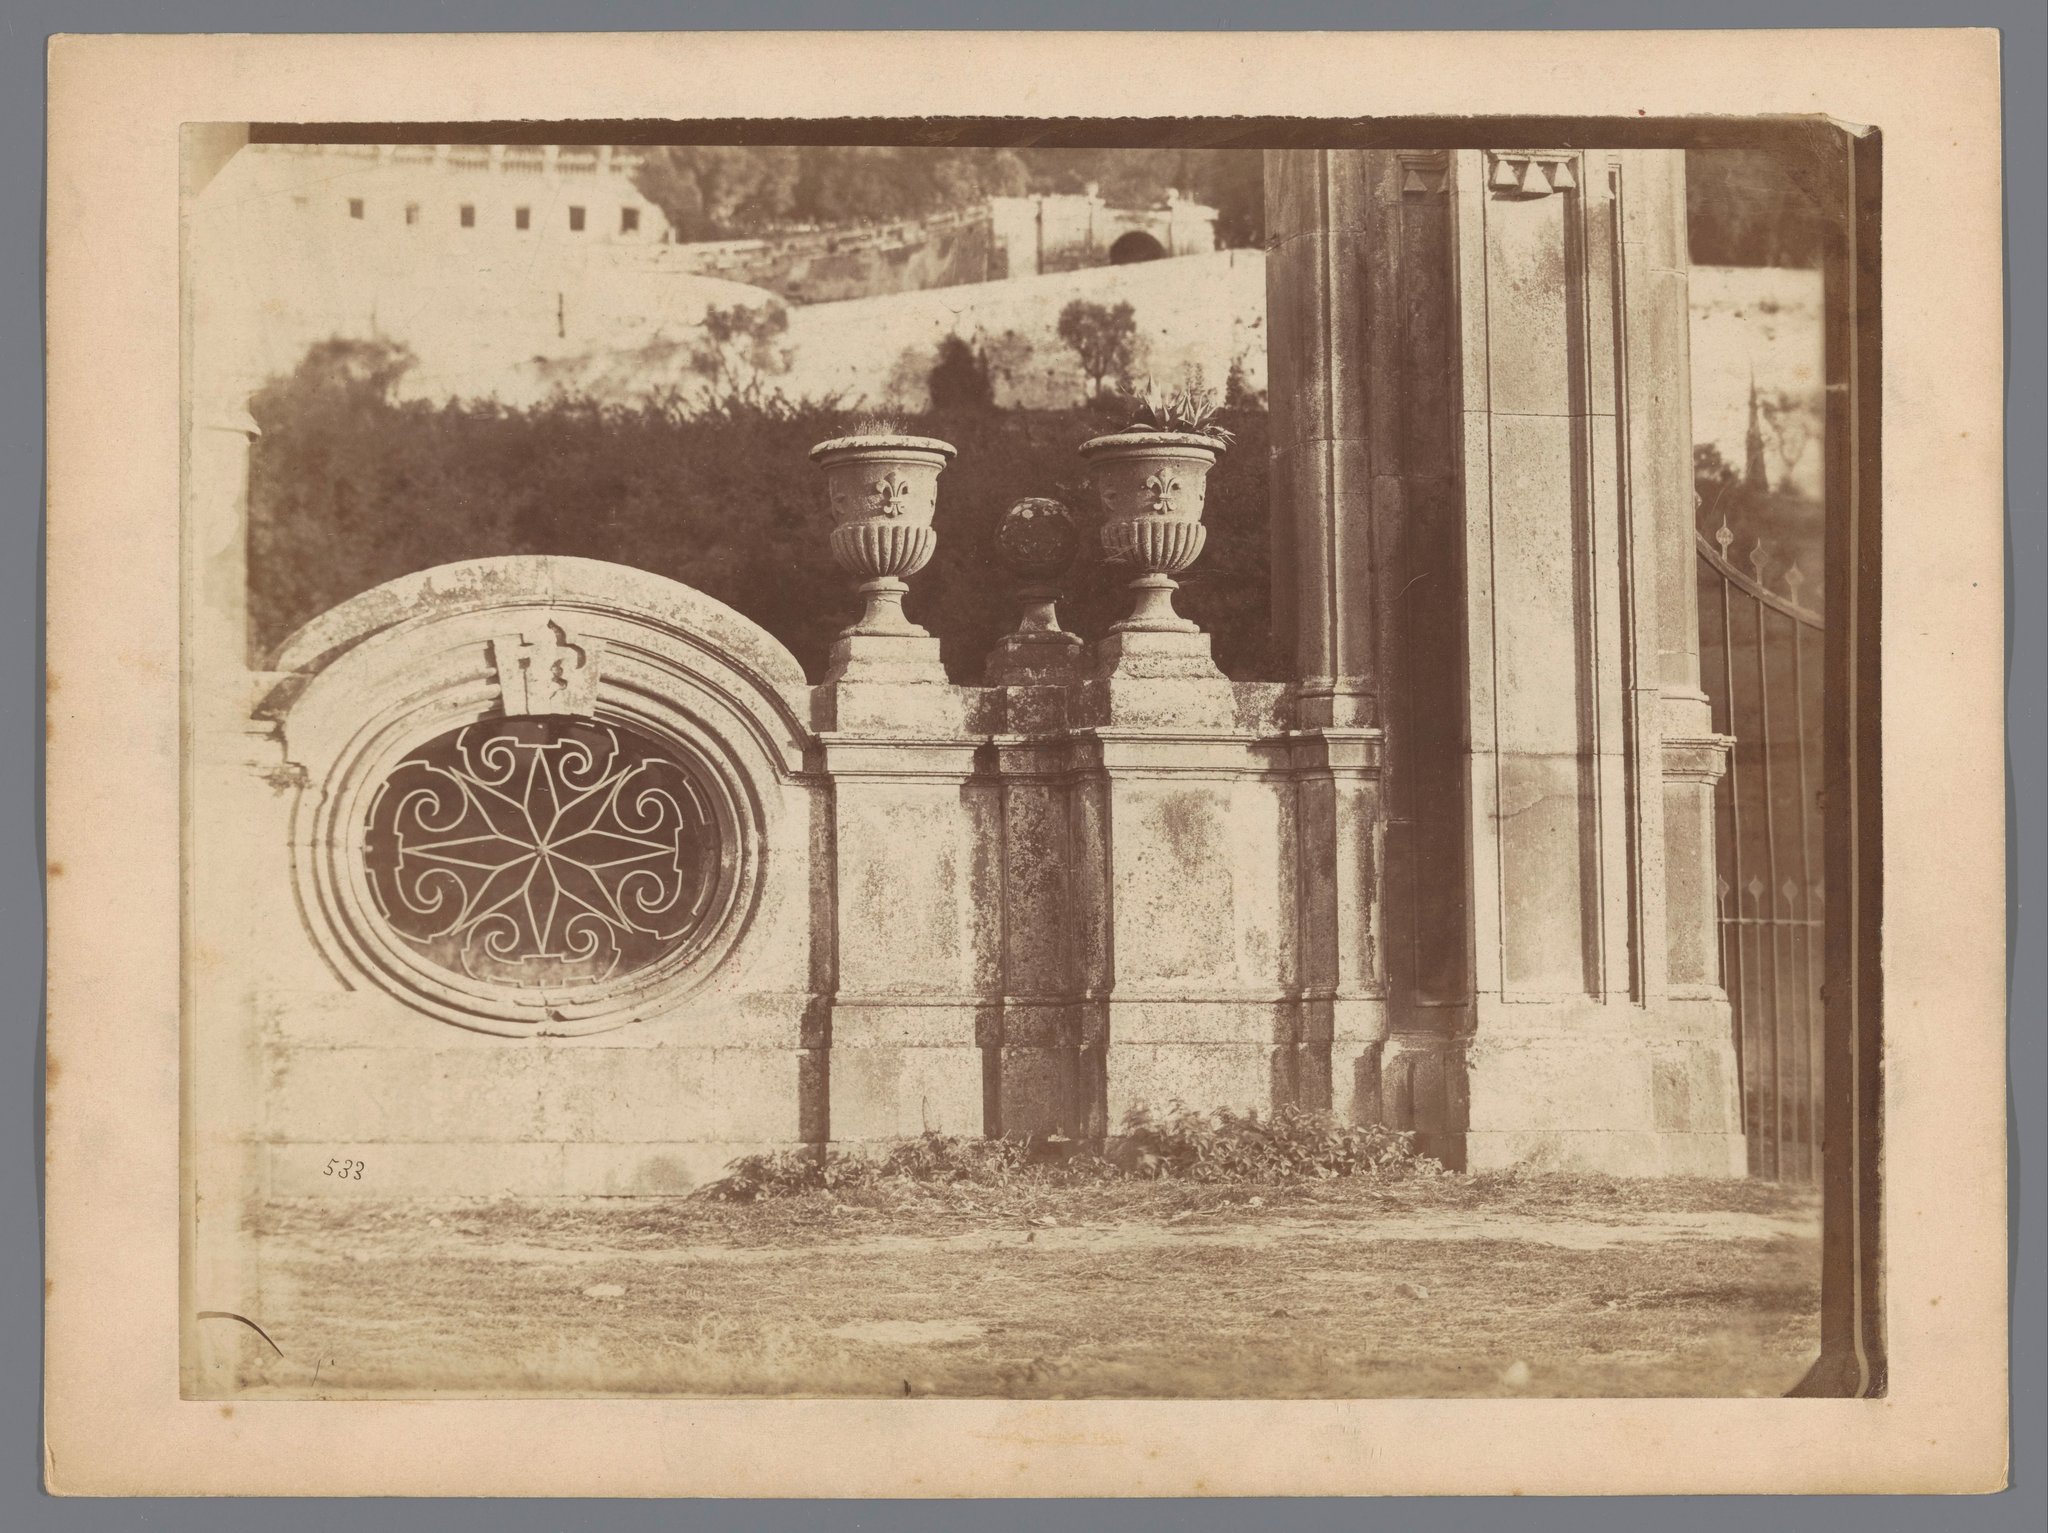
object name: photograph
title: Muur van de Villa Aldobrandini te Frascati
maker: gustave eugène chauffourier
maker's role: fotograaf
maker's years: 1845-1919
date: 1875-1900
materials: photographic support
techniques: albumen print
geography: frascati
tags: vase ~ ornament, fence, wall, paling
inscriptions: stamp: Lugt 3937, number: ‘533’